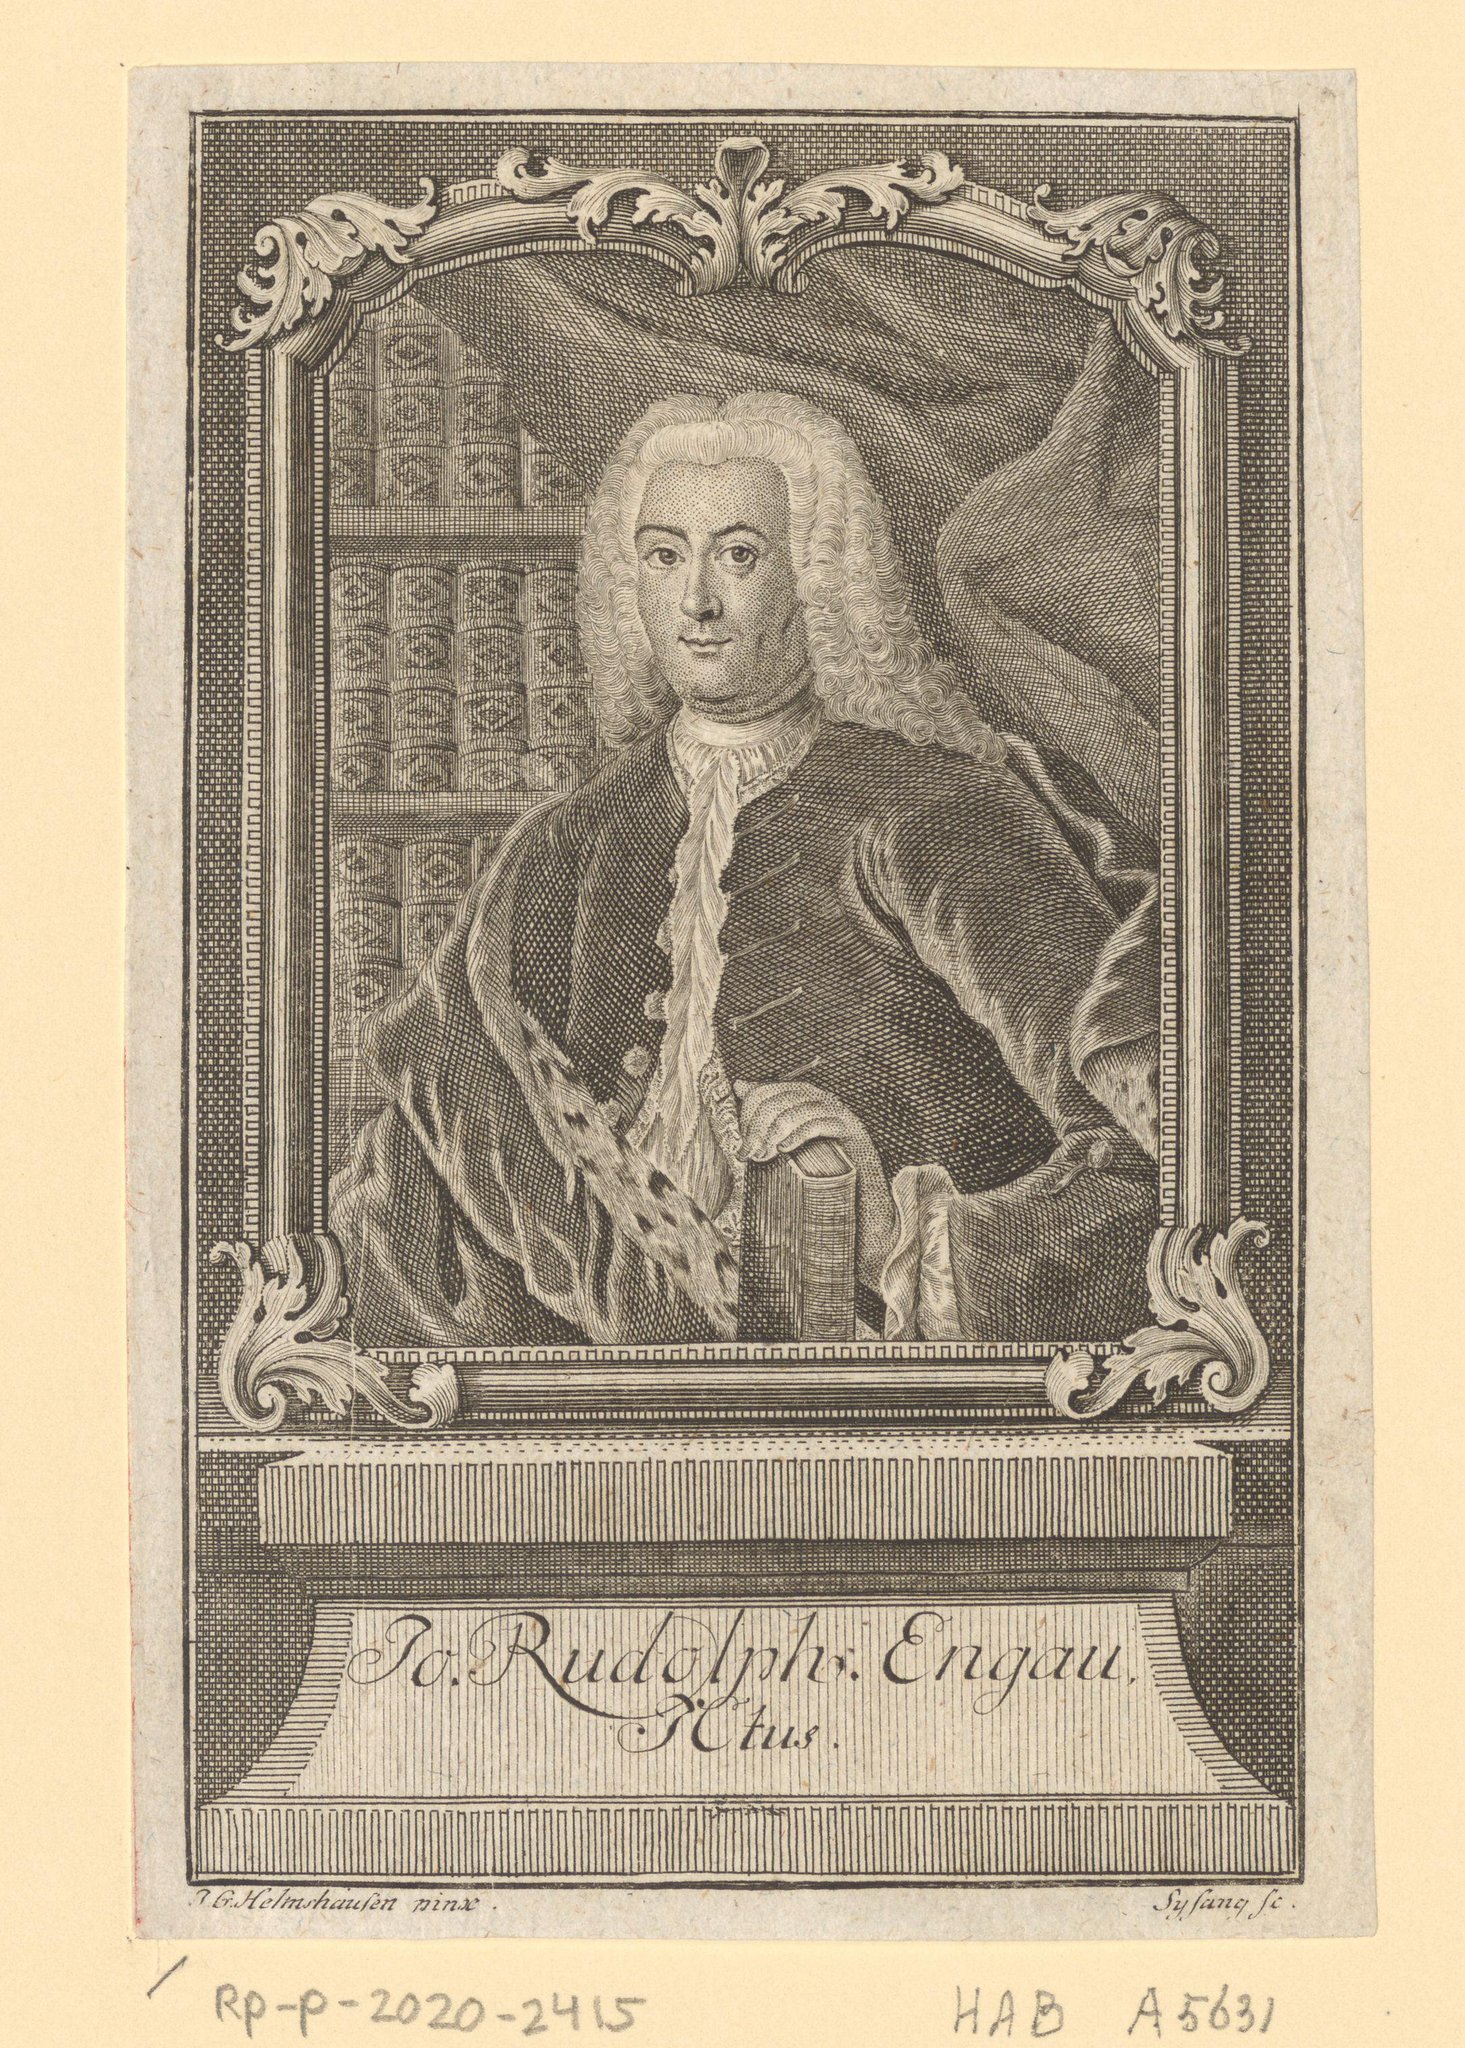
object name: print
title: Portret van Johann Rudolf Engau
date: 1738-1757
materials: paper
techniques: engraving, etching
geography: germany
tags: bookshelves, historical persons